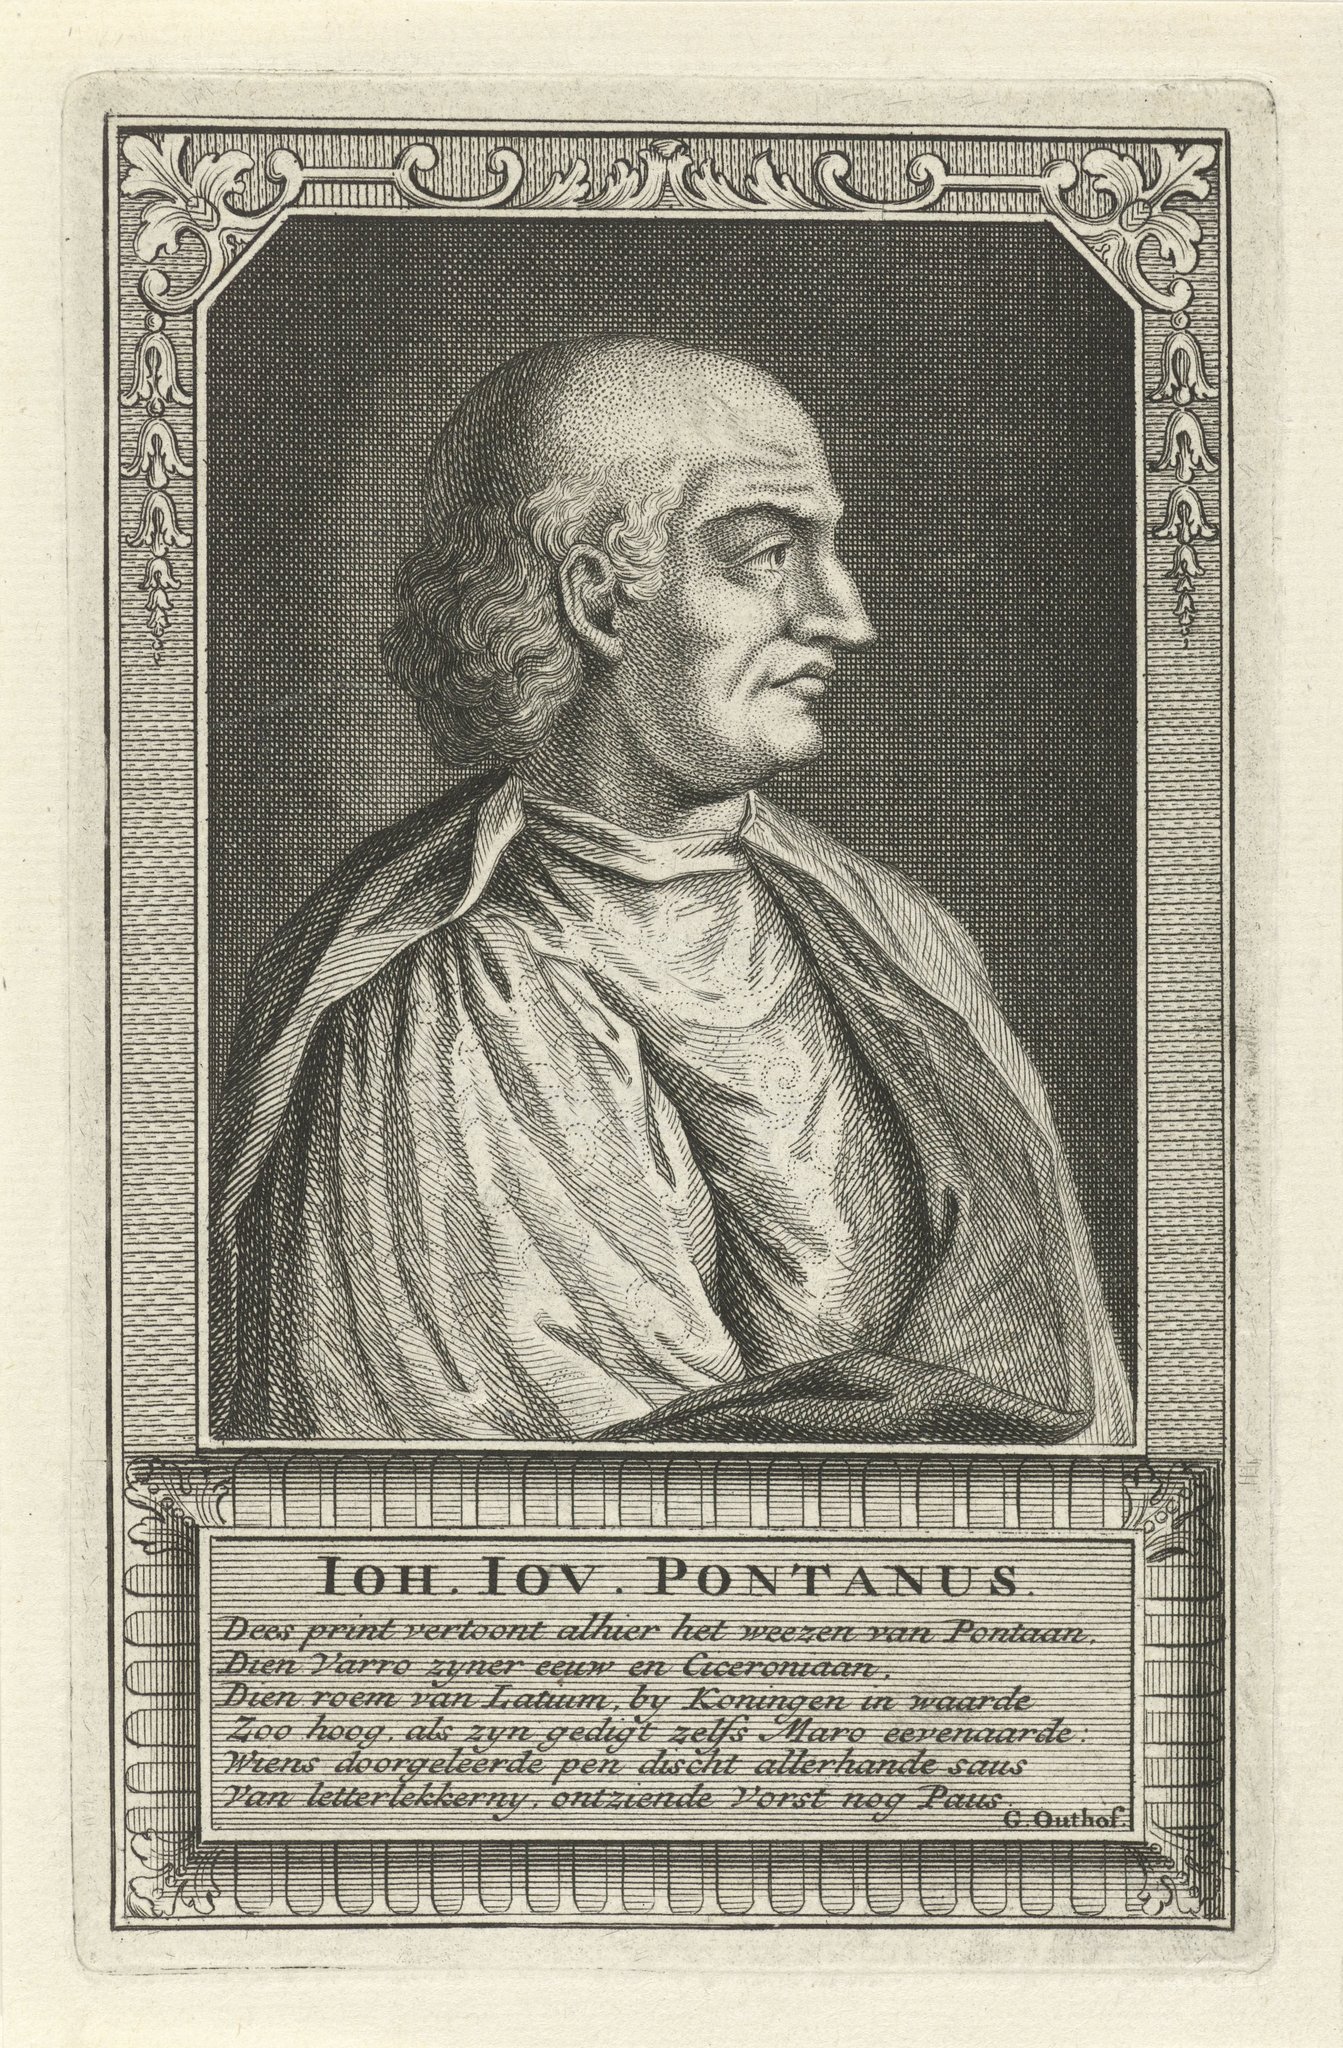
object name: print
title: Portret van Giovanni Gioviano Pontano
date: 1694-1755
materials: paper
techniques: engraving, etching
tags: naples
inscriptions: collector's mark: Lugt 2228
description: Portretbuste naar rechts van Giovanni Gioviano Pontano, Italiaans schrijver en dichter, blootshoofds. Rondom een ornamentele omlijsting, onder het portret de naam van de geportretteerde gevolgd door een zesregelig Nederlands vers.